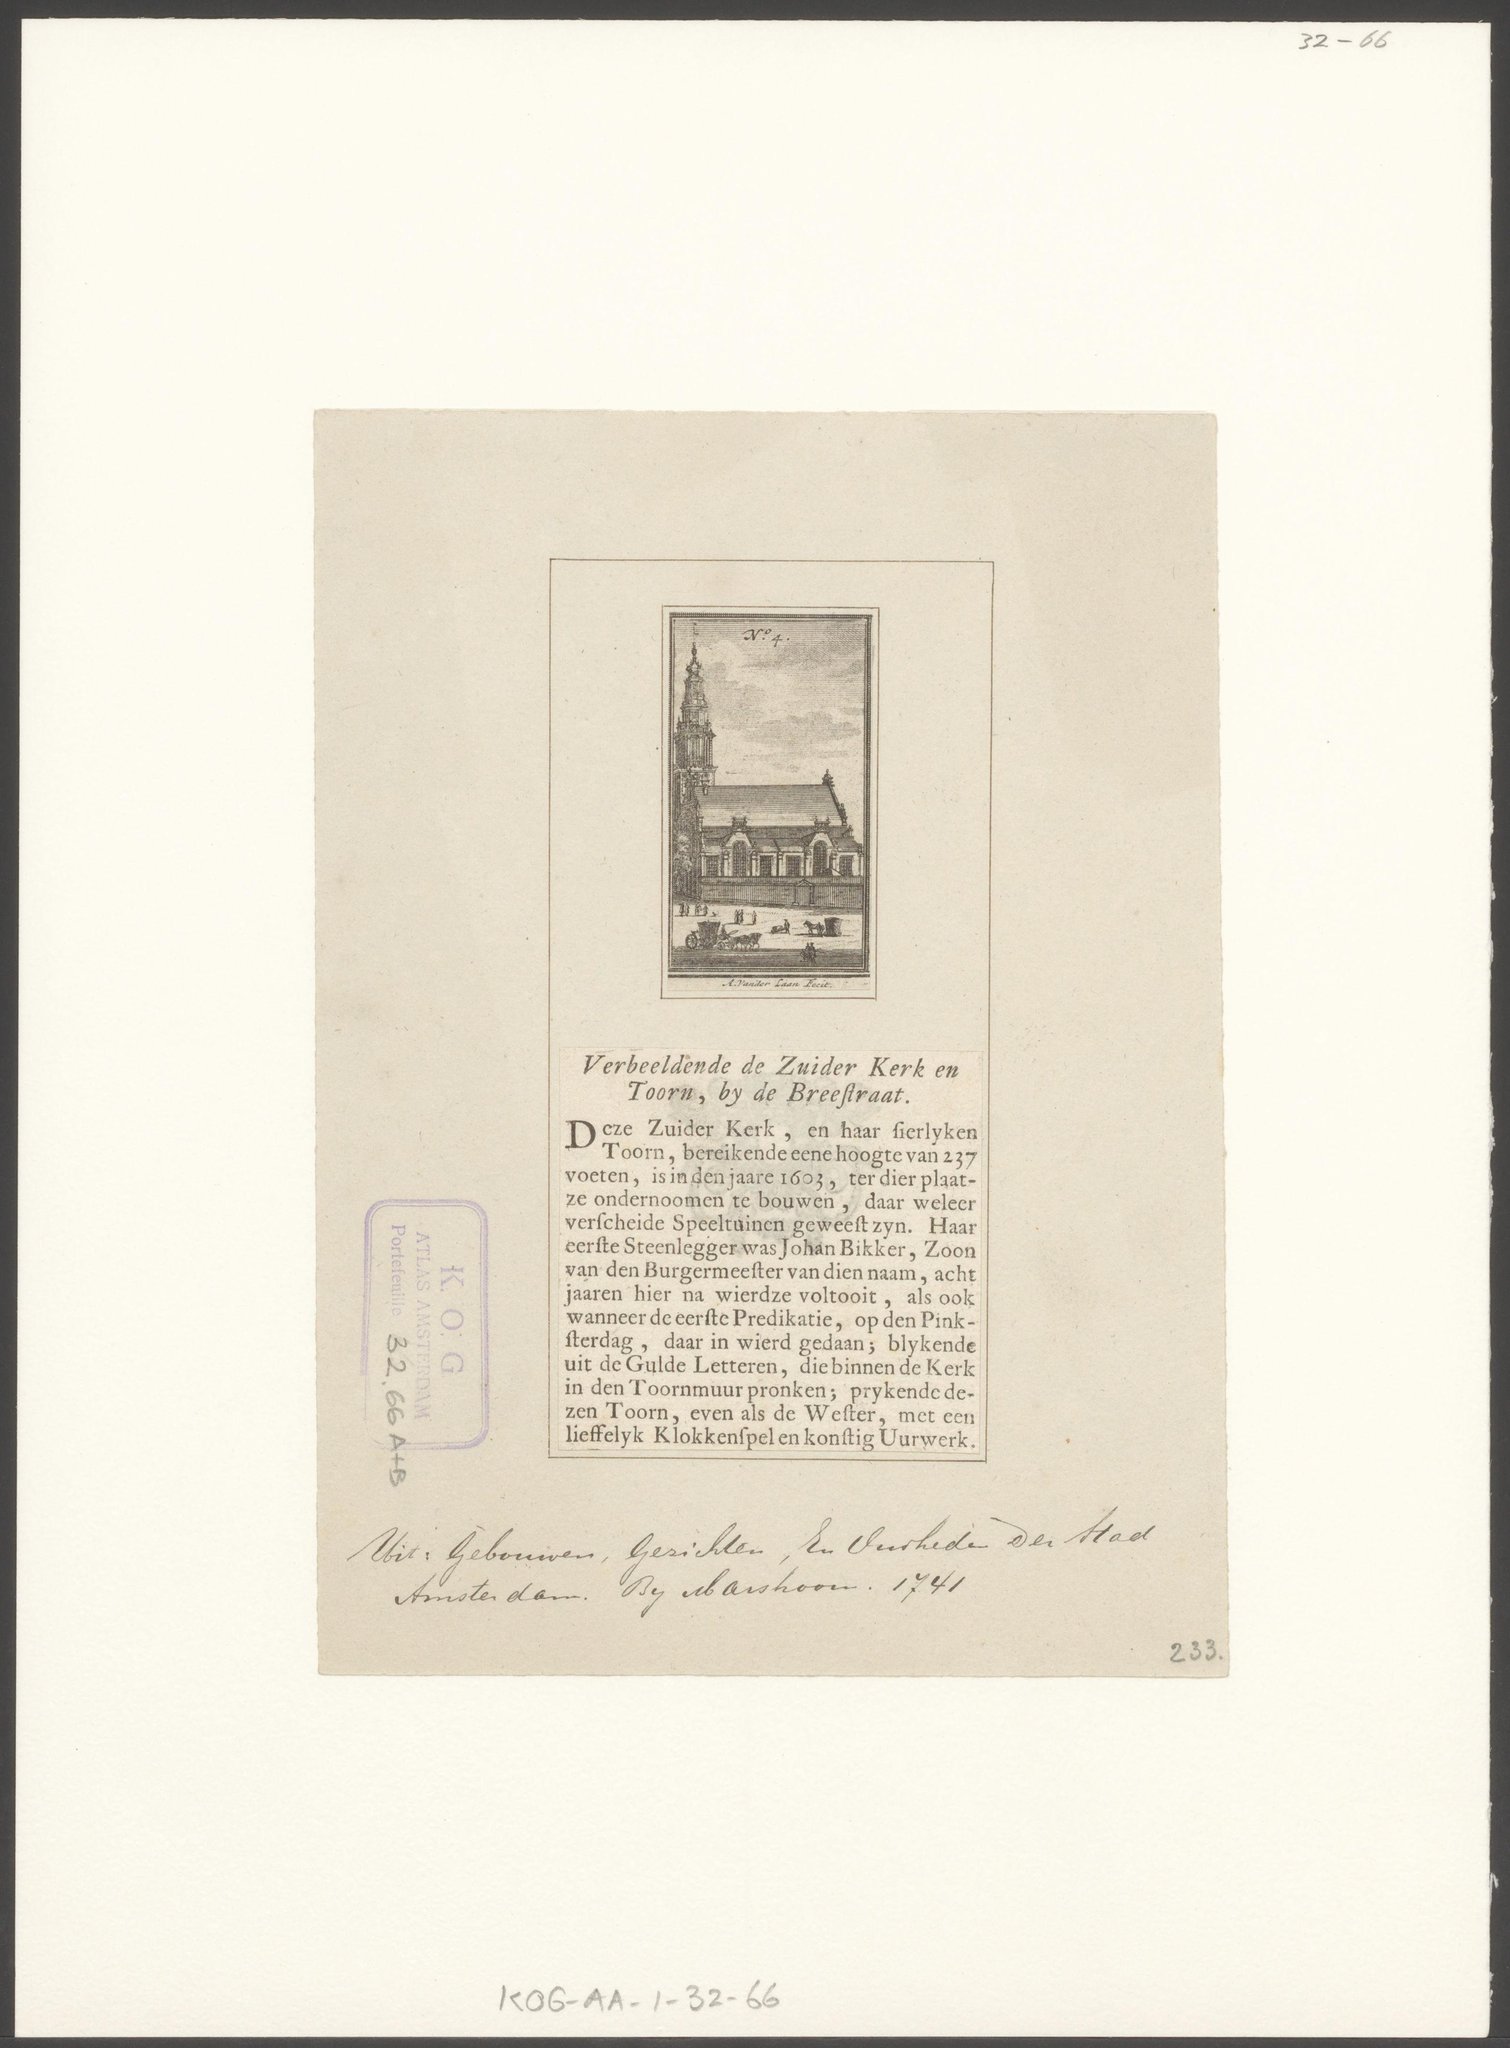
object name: book illustration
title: Gezicht op de Zuiderkerk te Amsterdam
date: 1736-1744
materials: paper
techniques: etching, letterpress printing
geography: northern netherlands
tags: church (exterior), street (+ city(-scape) with figures, staffage)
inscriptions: collector's mark: Lugt 1641b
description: Centraal bovenaan genummerd: No. 4. Onder de prent is een verklarend bijschrift van de prent geplakt. Onderwerpsrubriek binnen de Atlas Amsterdam: Kerkwezen: Hervormde Gemeente: Zuiderkerk.